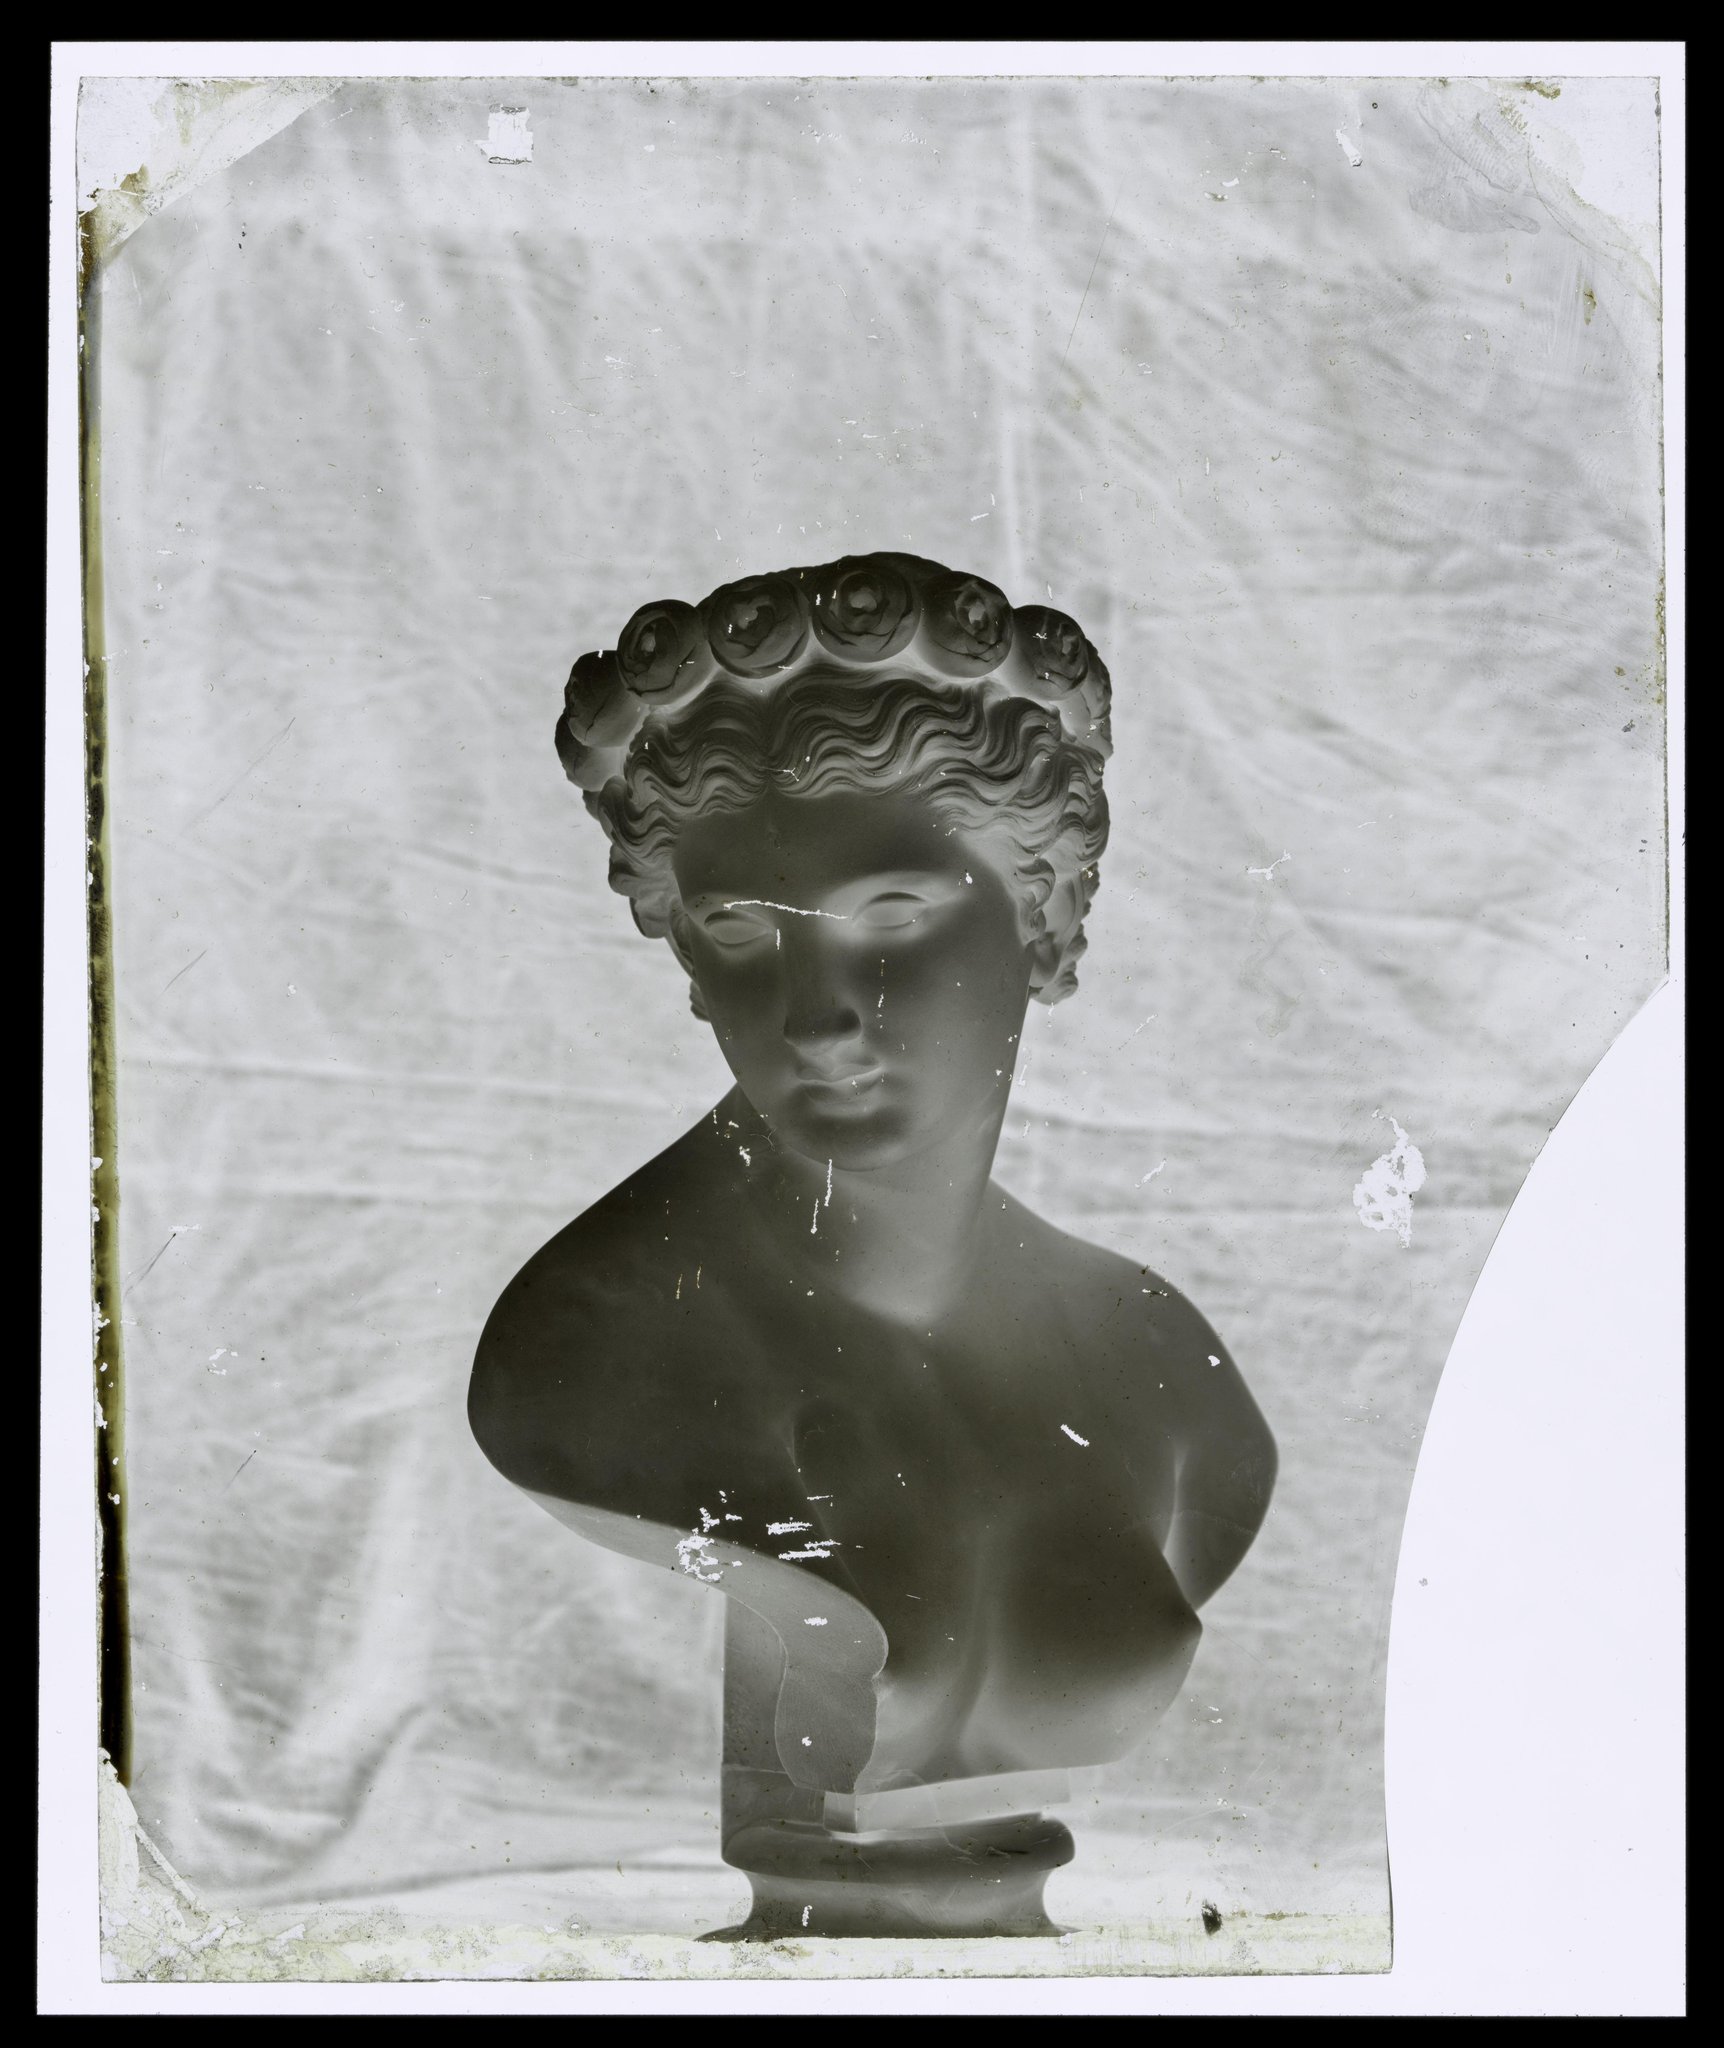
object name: glasnegatief, glasplaatnegatief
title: Borstbeeld van een vrouw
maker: laurens lodewijk kleijn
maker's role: draughtsman, painter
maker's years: 1826-1909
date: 1865-1900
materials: glass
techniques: collodion process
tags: sculpture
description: Onderdeel van een groep glasnegatieven uit de nalatenschap van de schilder Laurens Lodewijk Kleijn, met stillevens, portretten, zelfportretten en kunstreproducties.